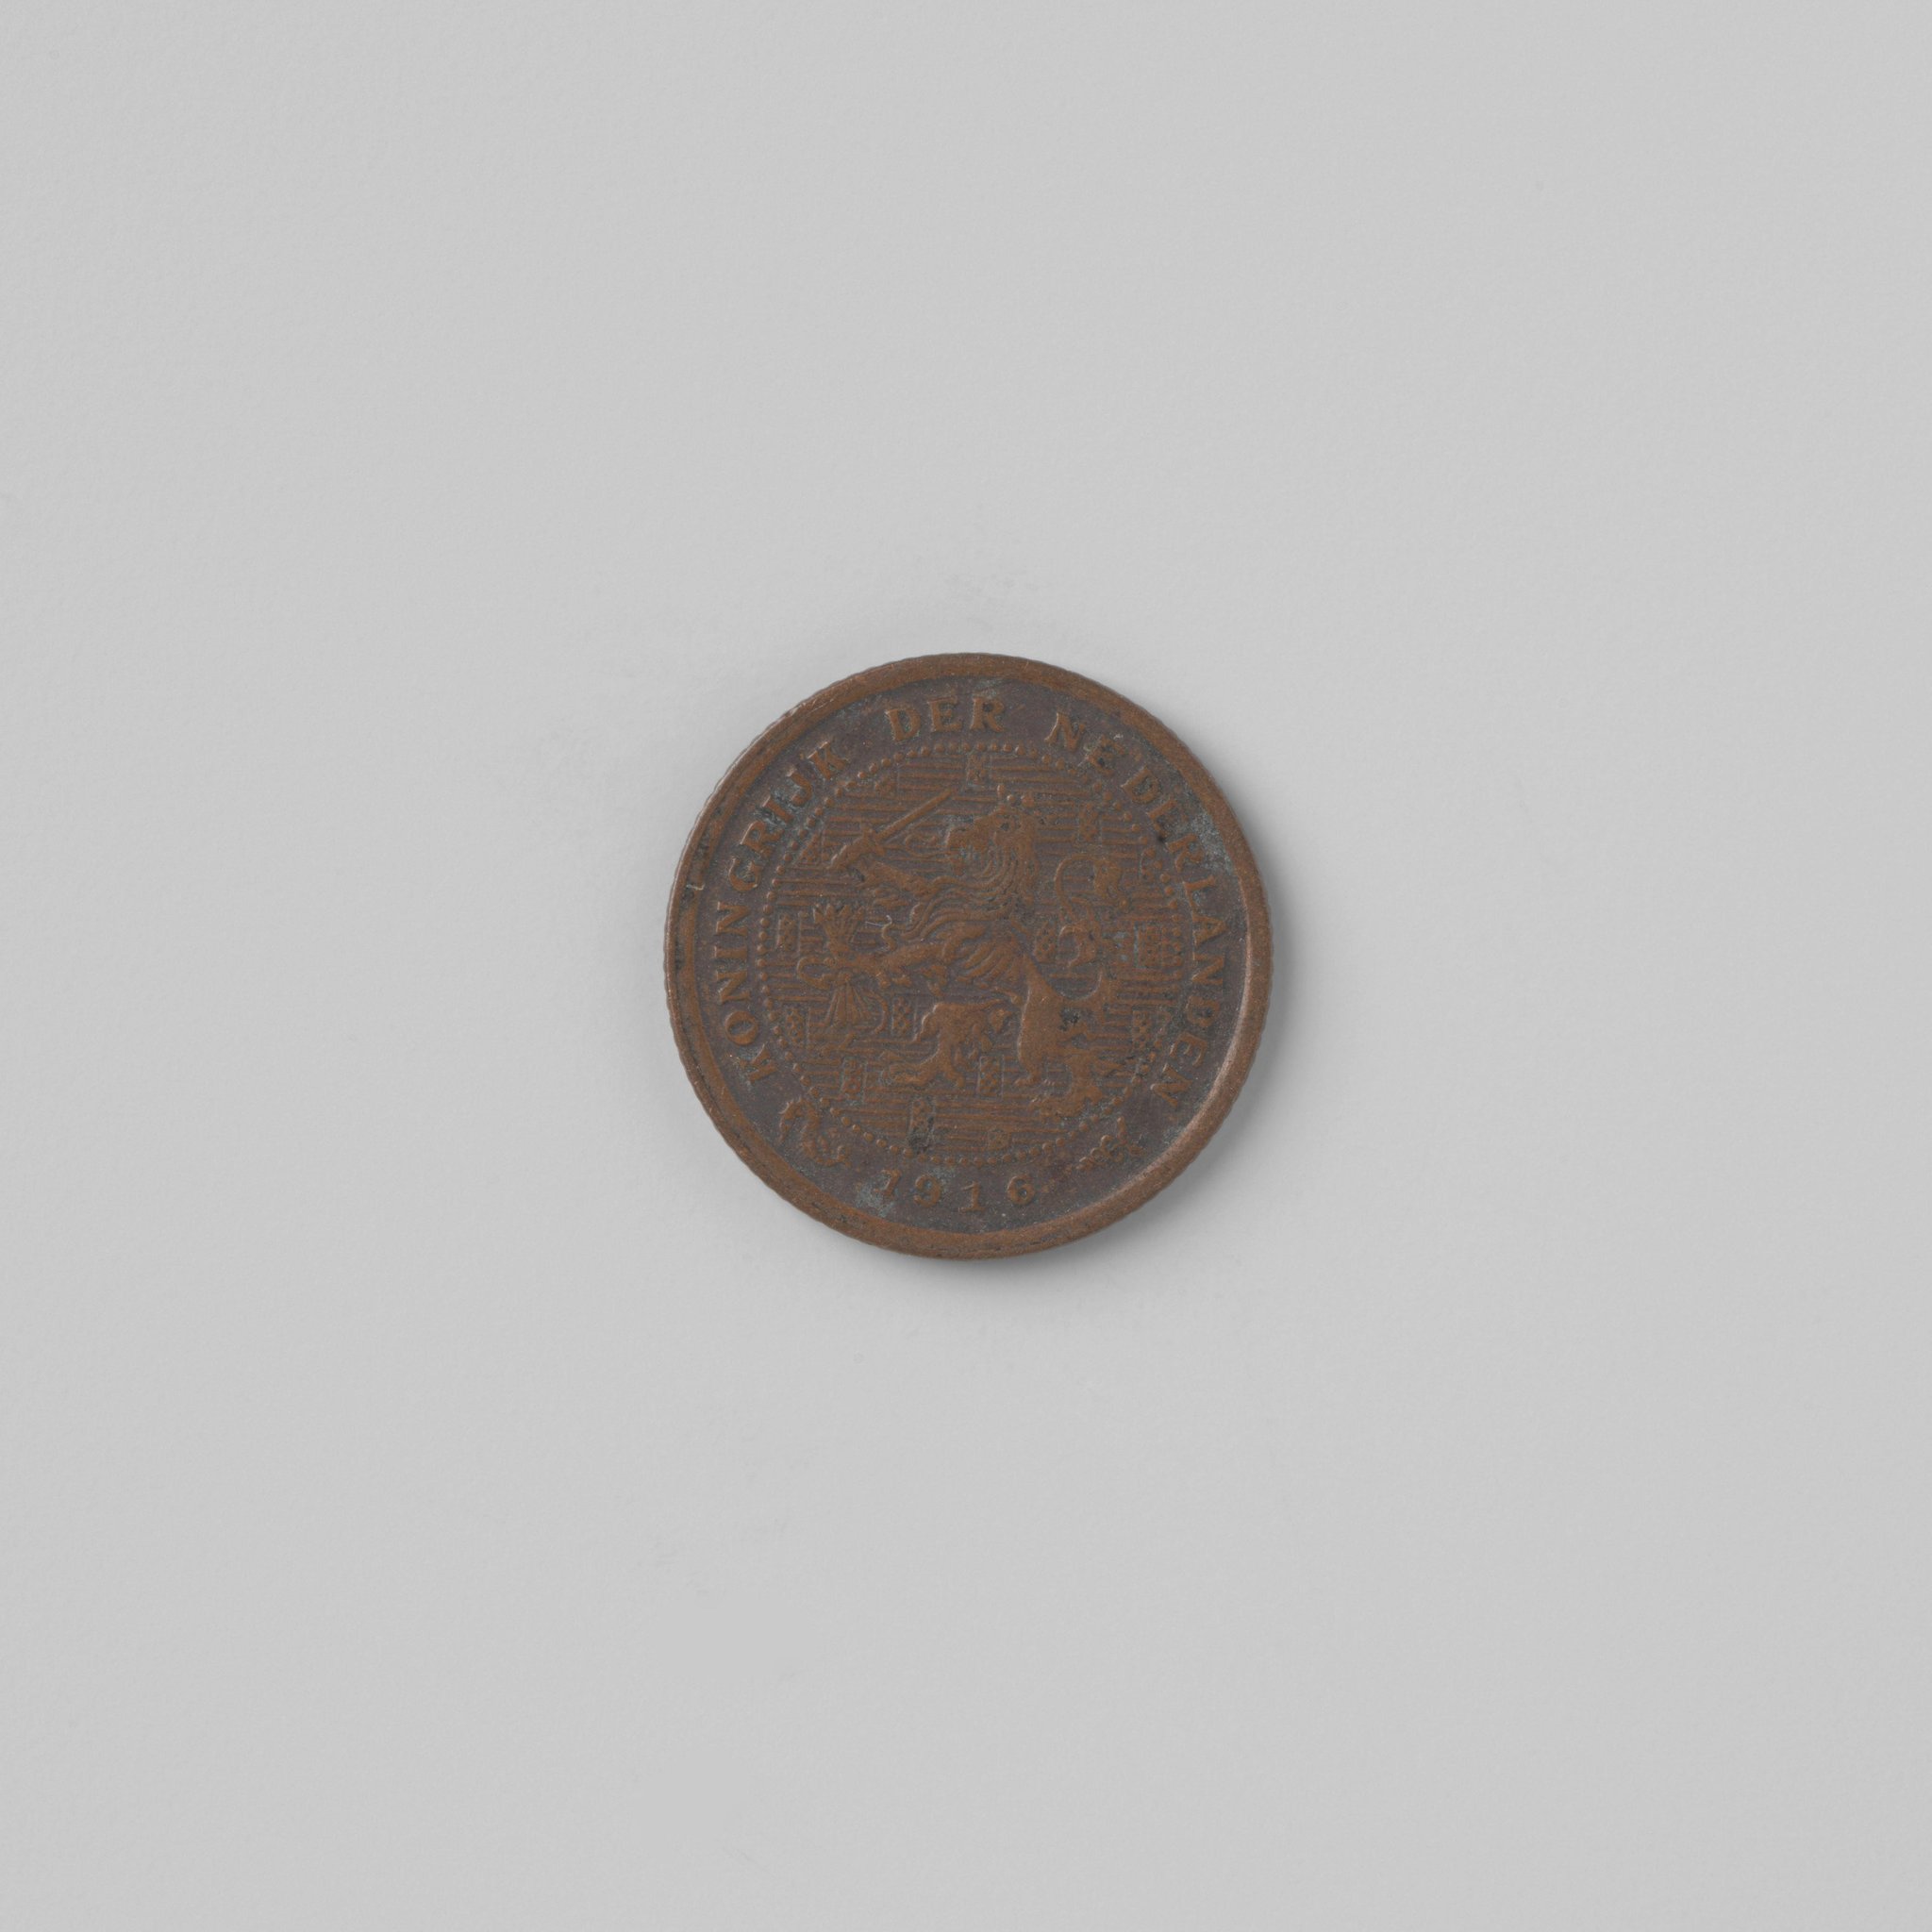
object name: coin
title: Nederlandse ½ cent,1916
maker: wilhelmina of the netherlands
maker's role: print maker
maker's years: 1880-1962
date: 1916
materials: bronze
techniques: striking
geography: utrecht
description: Bronzen munt. Voorzijde: in een veld rijkswapen. Jaartal onderaan in omschrift. Keerzijde: binnen twee samengebonden oranjetakken waarde-aanduiding ½ cent. Kartelrand.